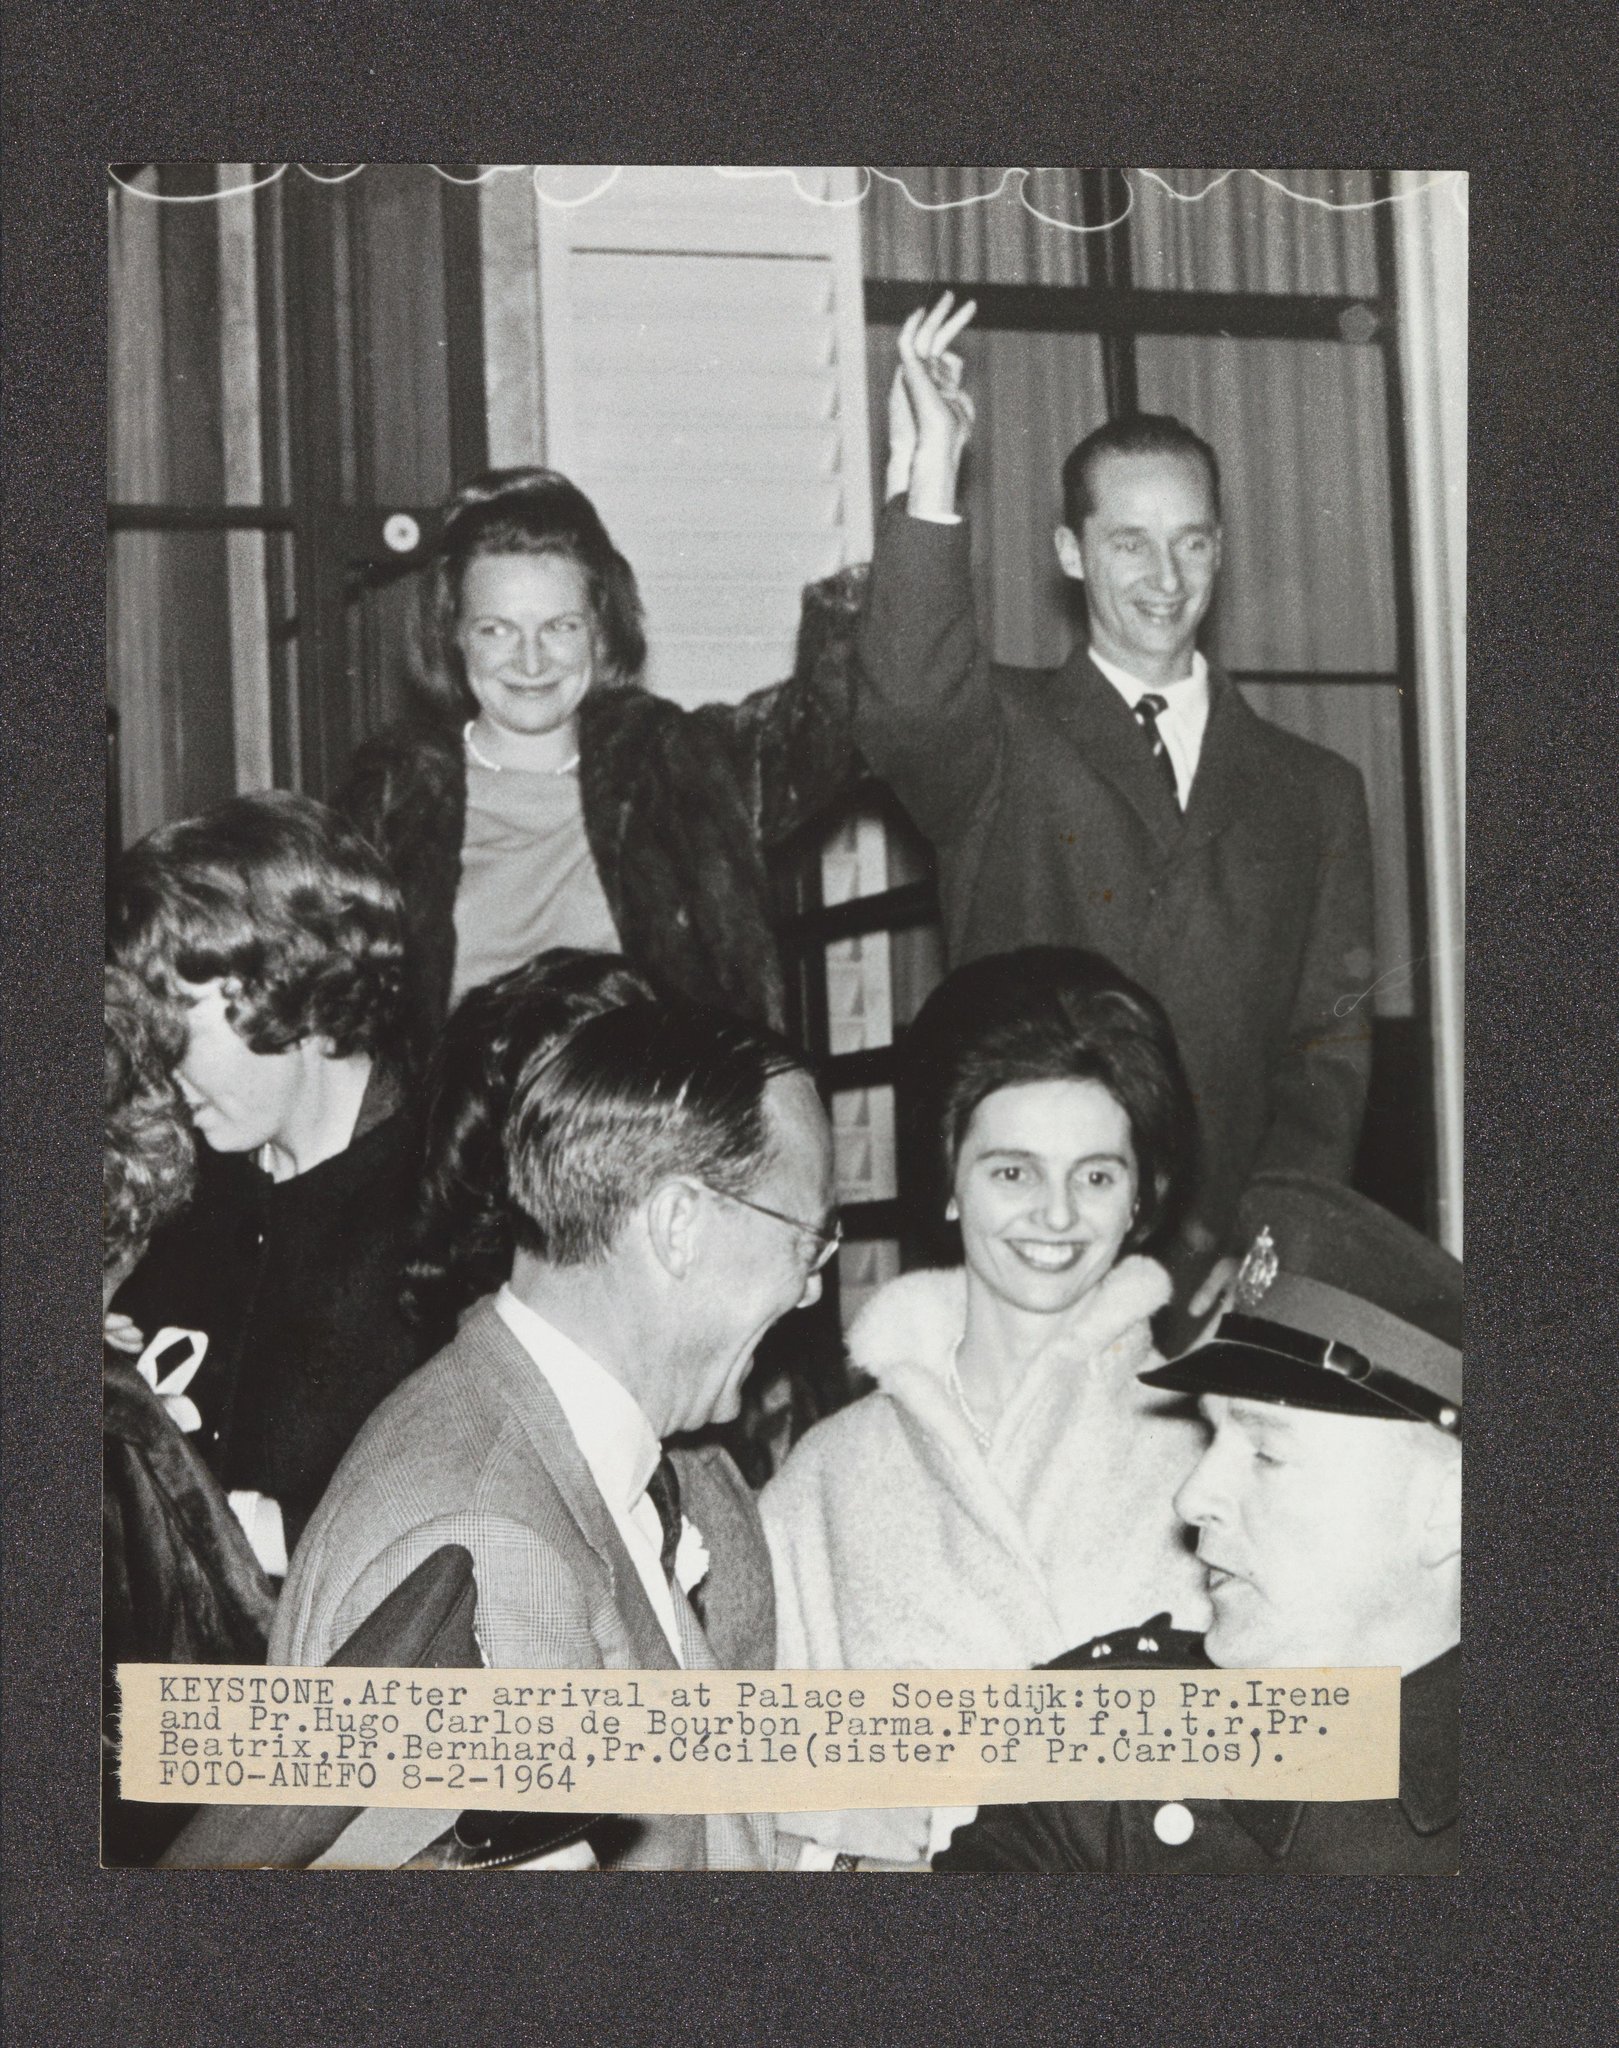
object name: photograph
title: After arrival at Palace Soestdijk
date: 1964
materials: paper, photographic support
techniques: gelatin silver print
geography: netherlands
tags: utrecht, bernhard (prins der nederlanden), paris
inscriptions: annotation: ‘Keystone. After arrival at Palace Soestdijk: top Pr. Irene and Pr. Hugo Carlos de Bourbon Parma. Front f.l.t.r. Pr. Beatrix, Pr. Bernhard, Pr. Cecile (sister of Pr. Carlos). Foto ANEFO 8-2-1964’